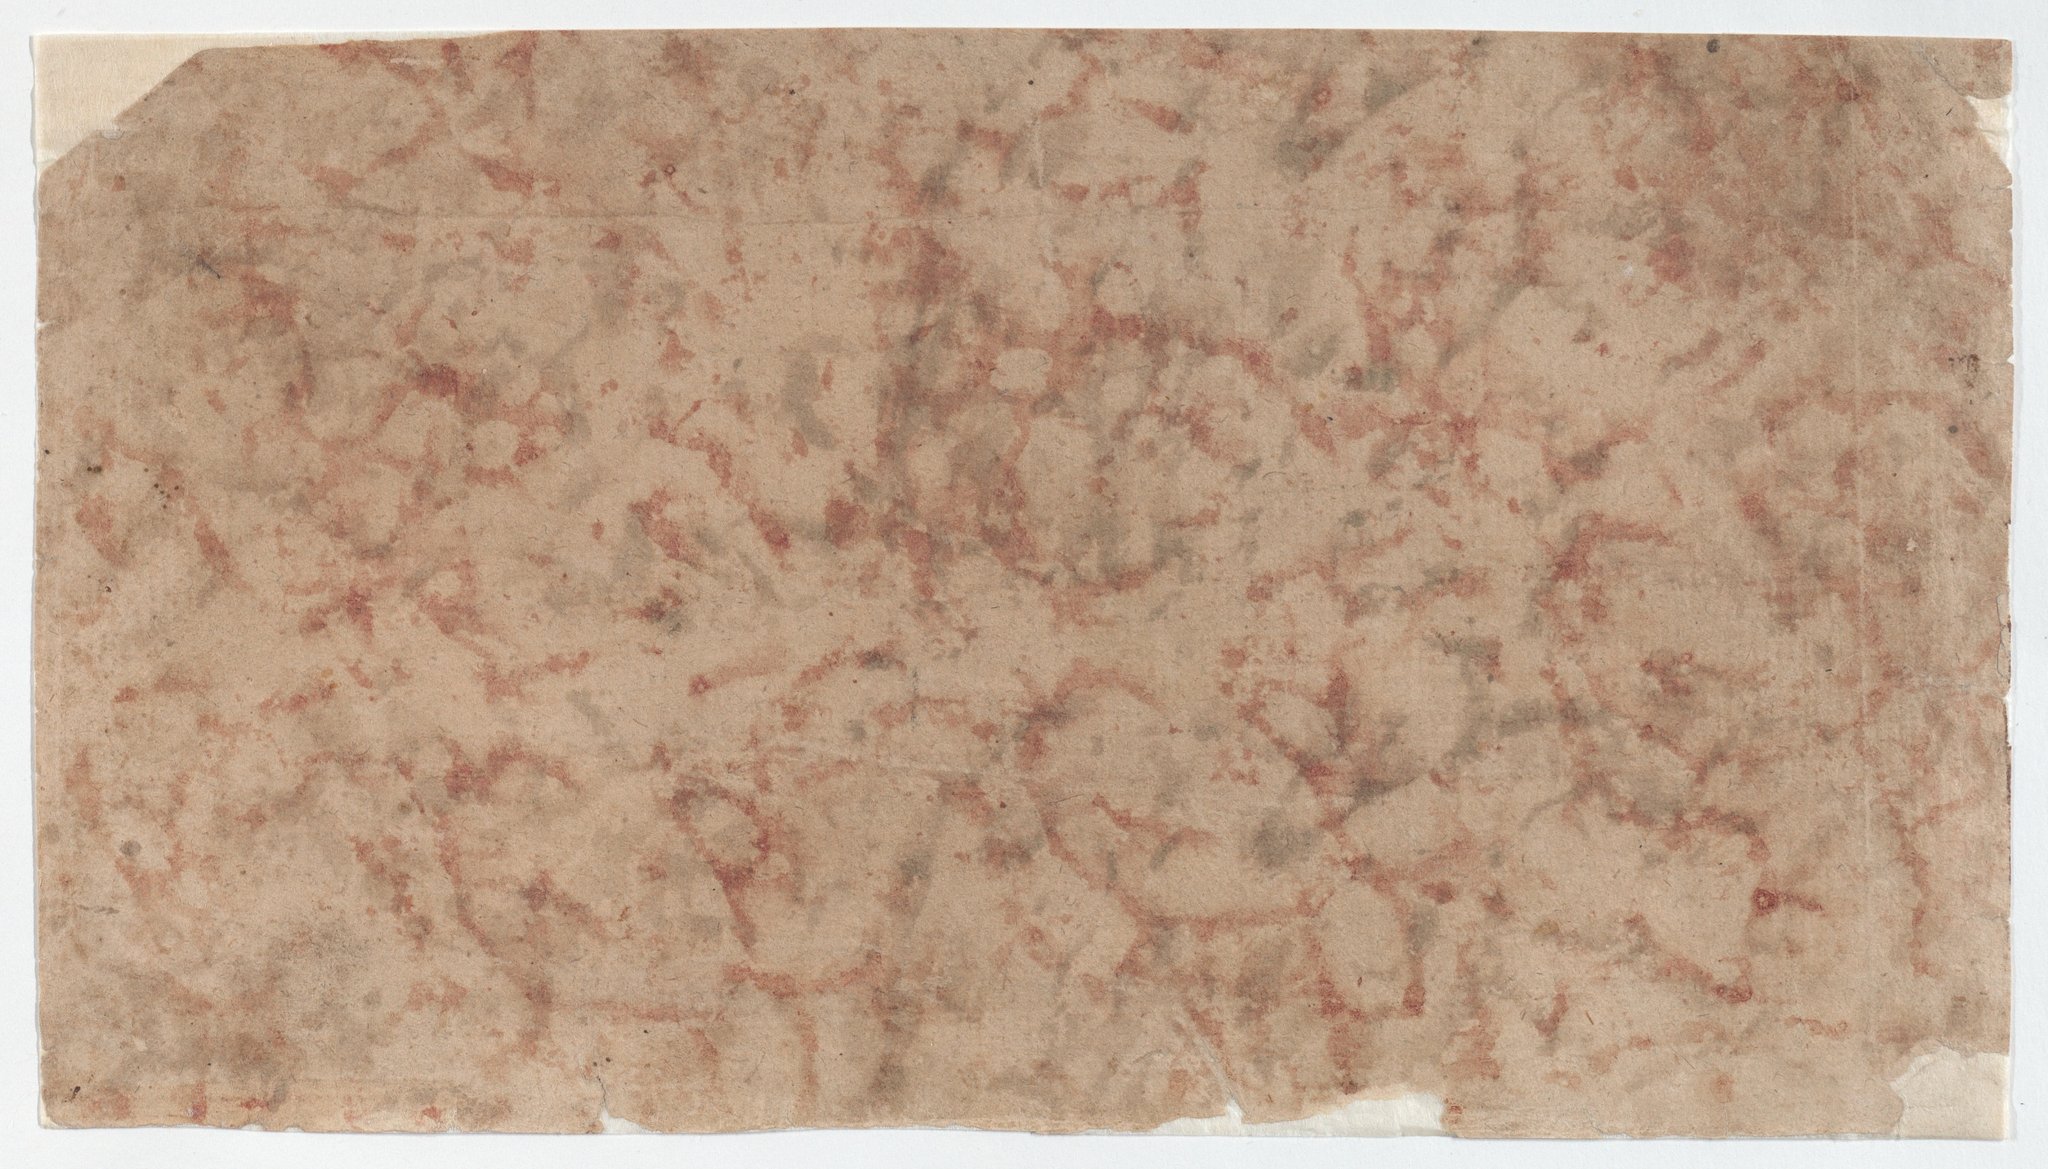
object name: print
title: Sheet with overall spotted design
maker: Anonymous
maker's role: artist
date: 1801-1900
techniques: relief print